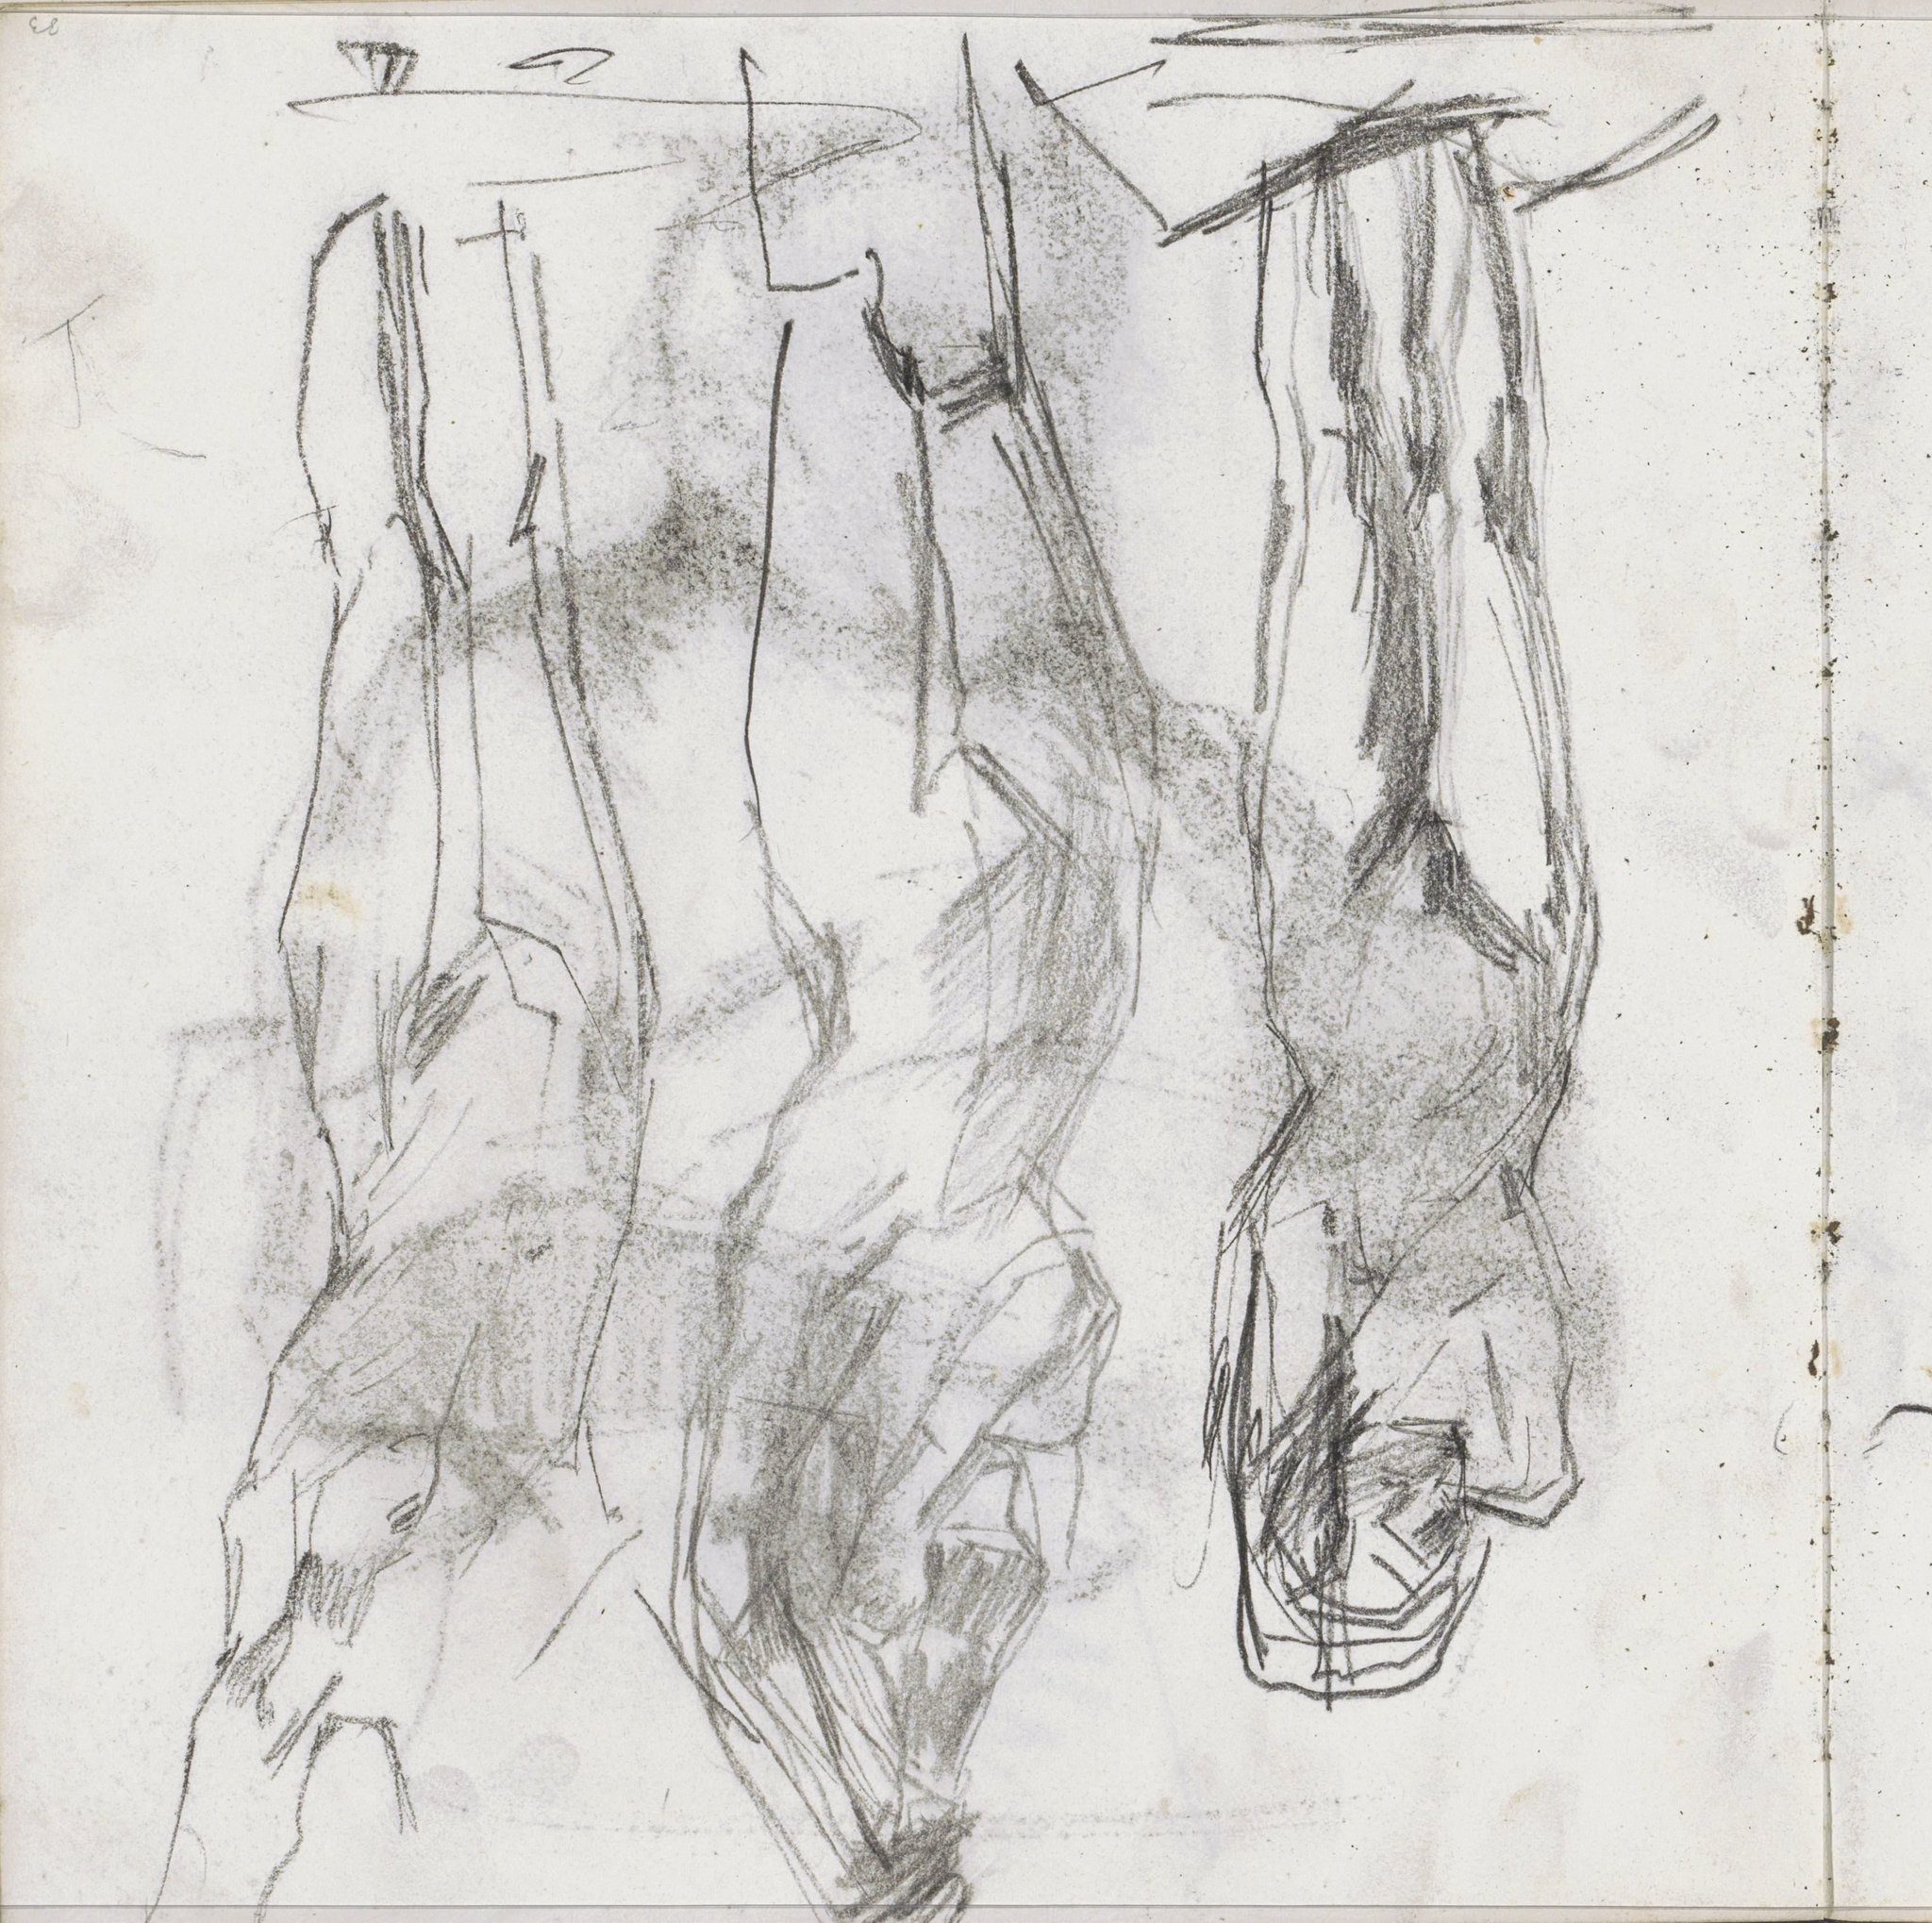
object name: sketchbook leaf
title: Drie staande vrouwelijke naakten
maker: isaac israels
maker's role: draughtsman, painter, print maker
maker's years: 1865-1934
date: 1875-1934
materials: chalk, paper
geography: the hague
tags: the (nude) human figure; 'corpo humano' (ripa) - aa - female human figure (+ standing)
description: Ze zijn bezig met hun haar. Blad 24 verso uit schetsboek IX met 28 bladen.